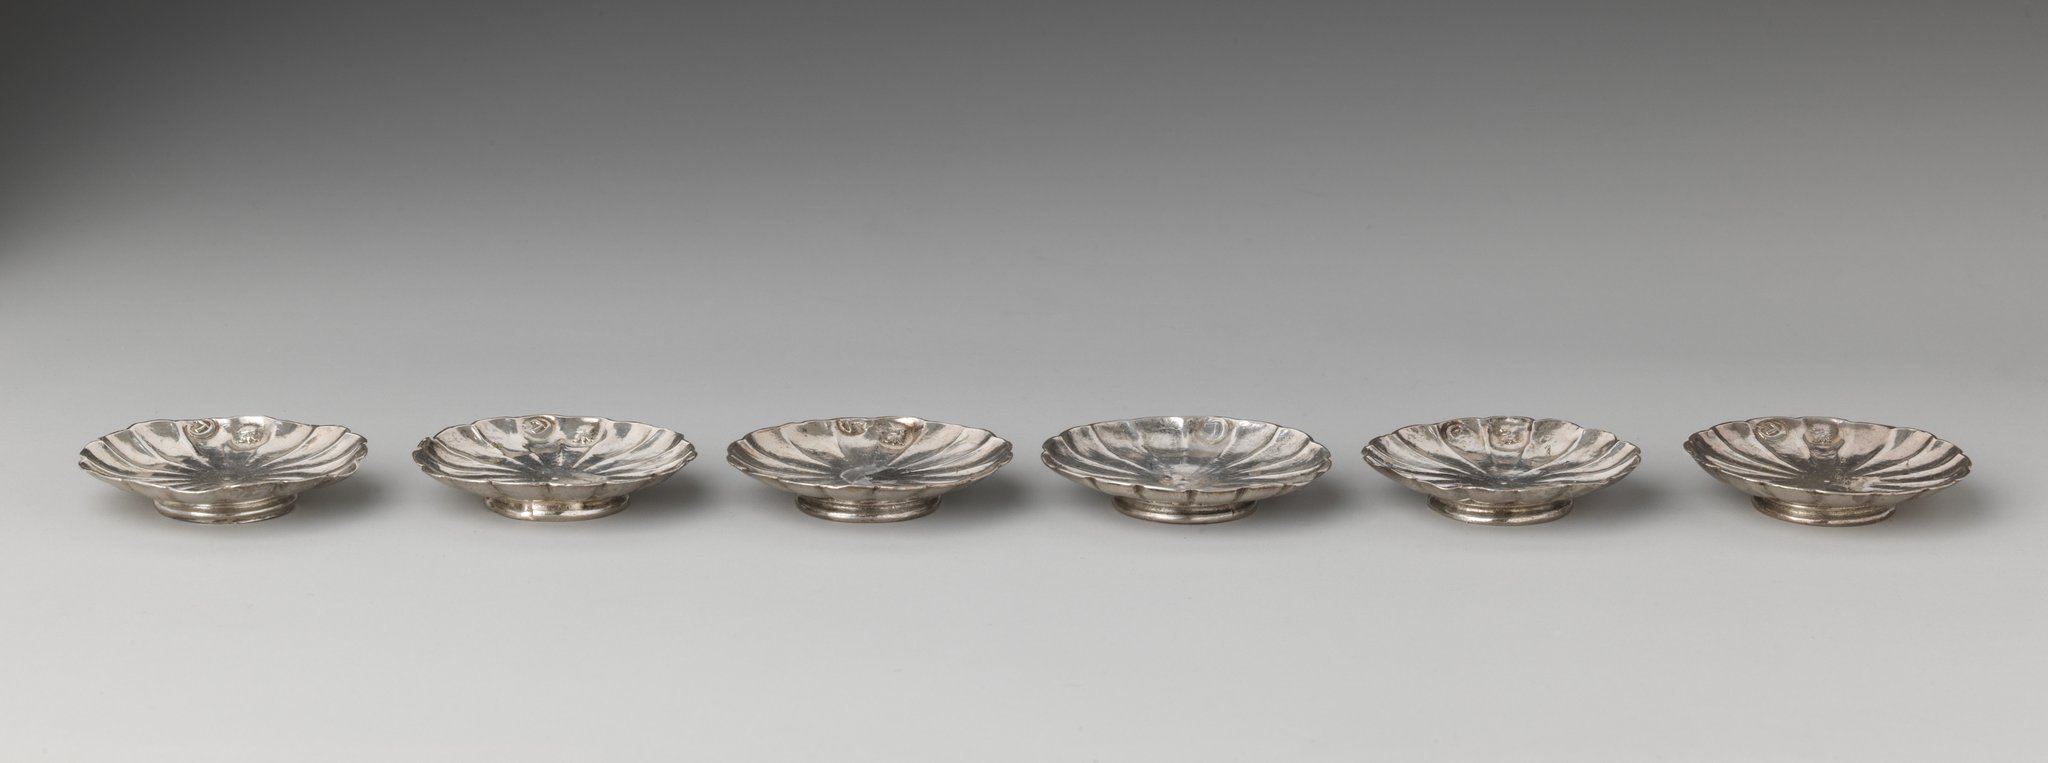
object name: saucer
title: Six miniature saucers (part of a set)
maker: david clayton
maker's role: maker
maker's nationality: british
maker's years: 1659-1719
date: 1667-1733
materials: silver